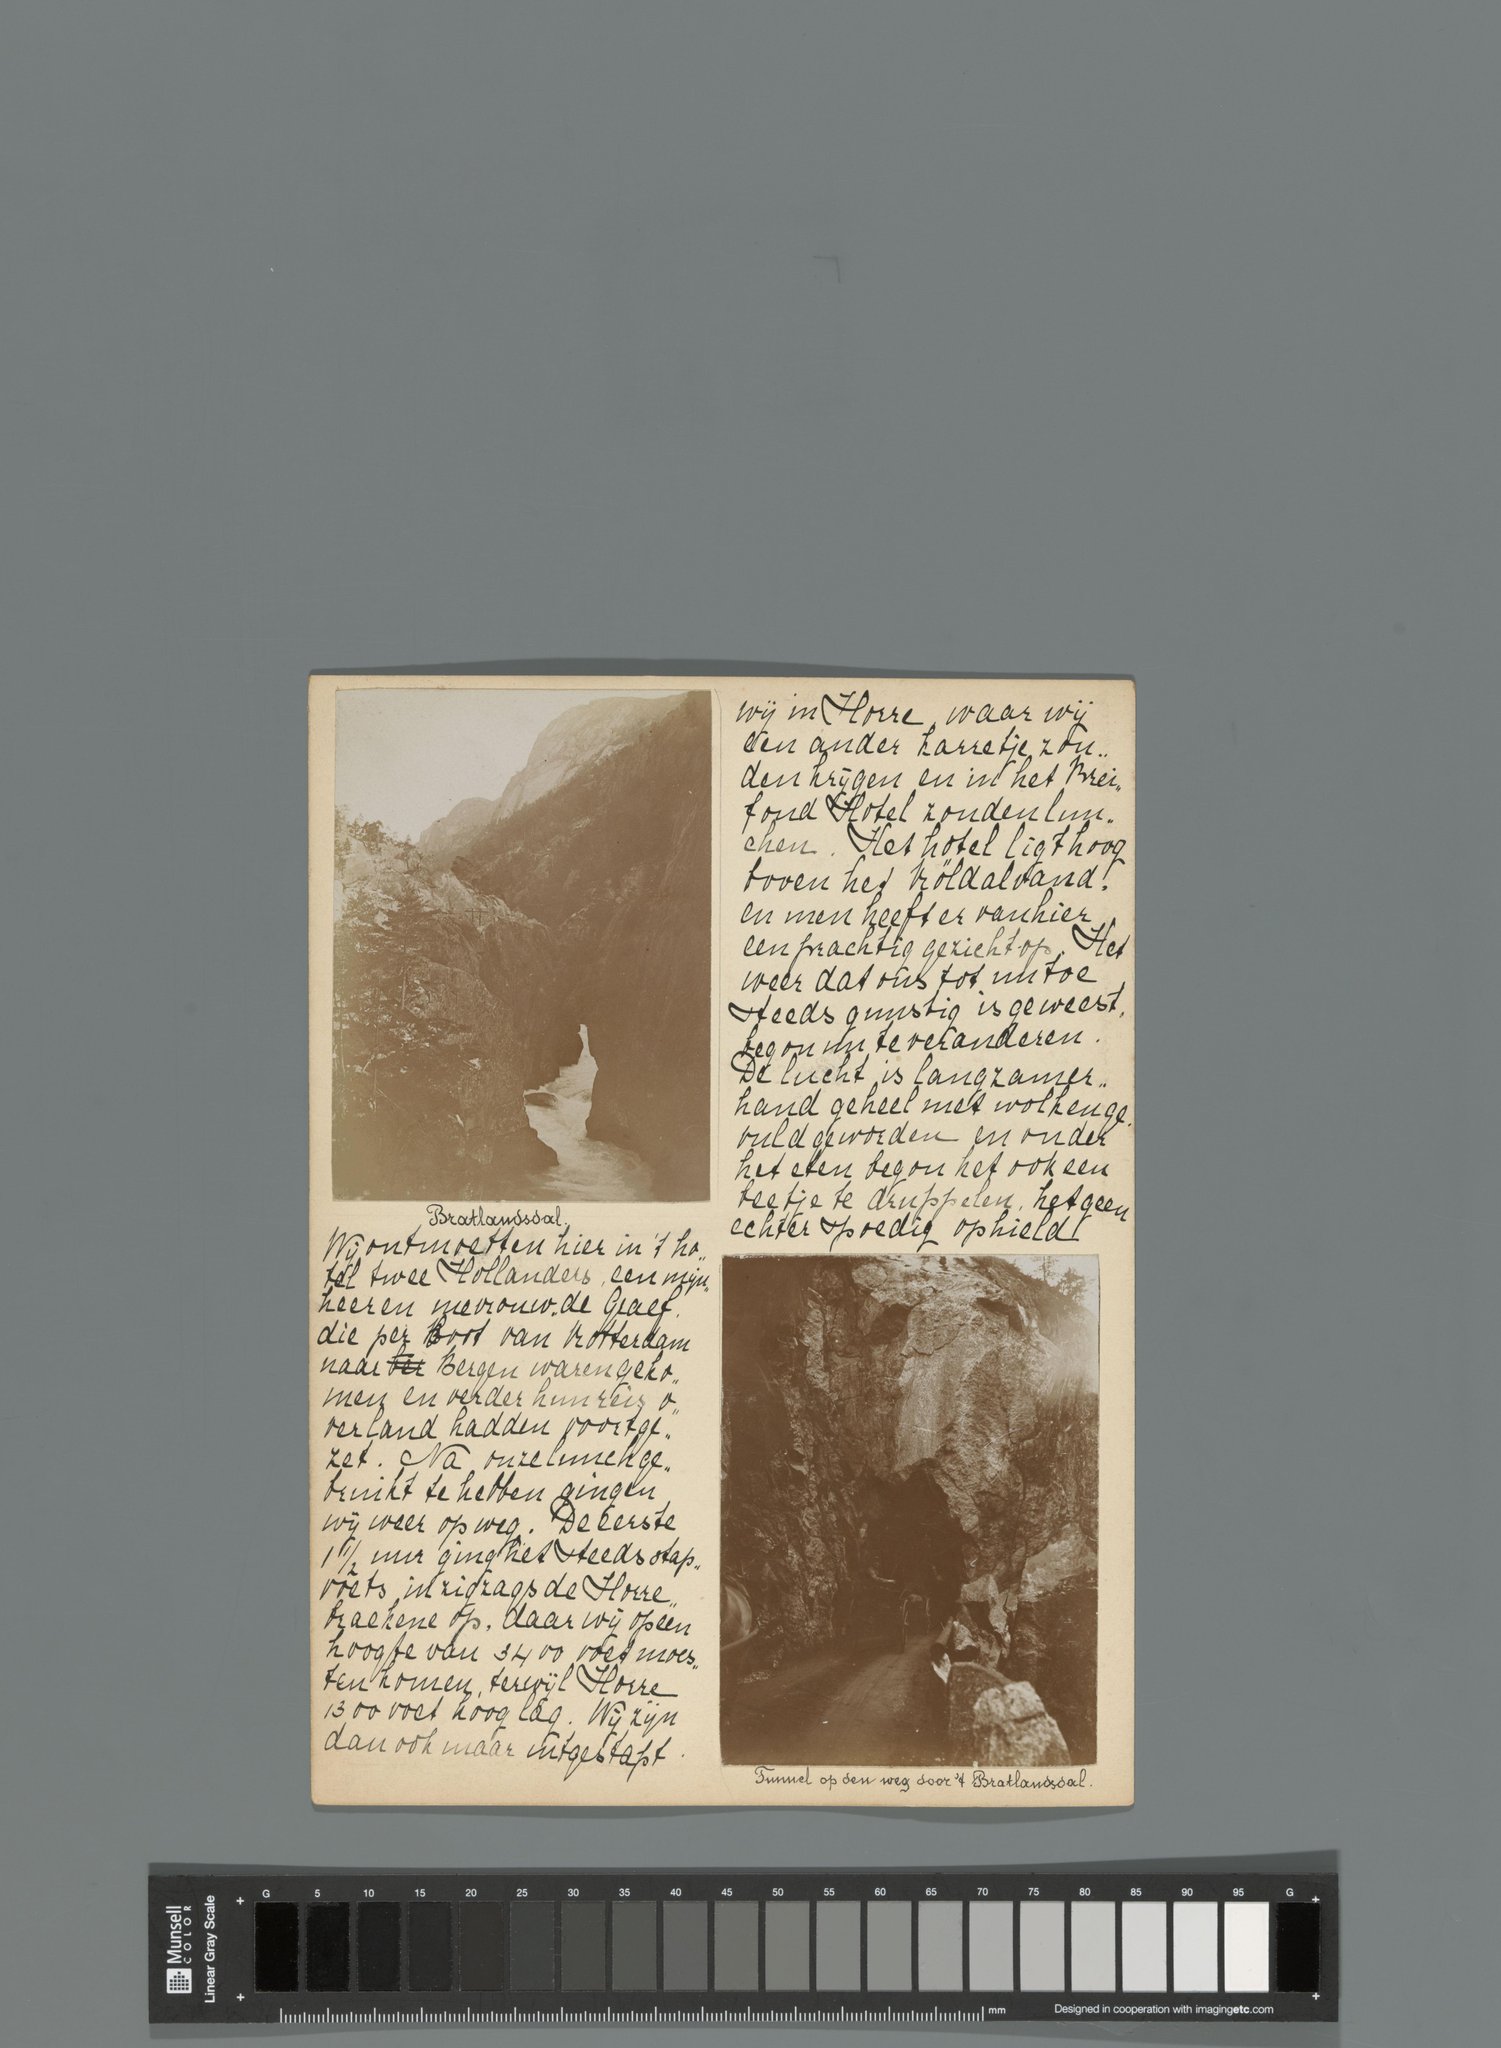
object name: diary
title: Zestiende pagina van een dagboek van een reis door Noorwegen met twee foto's met gezichten op Brattlandsdalen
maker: hendrik herman van den berg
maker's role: amateurfotograaf, jurist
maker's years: 1875-1944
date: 1895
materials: paper, ink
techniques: pen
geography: brattlandsdalen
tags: batavia, amsterdam, hendrik herman van den berg, ravine, chasm, abyss, canyon, handwriting, written text, 'en route', traveller under way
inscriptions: caption: ‘Bratlandsdal./ Tunnel op den weg door 't Bratlandsdal.’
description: Vijftiende pagina van een dagboek met het verslag van een reis door Noorwegen gemaakt door Hendrik Herman van den Berg en zijn neef Guillaume Louis Jacques Holle tussen 5 en 20 juli 1895. Op het dagboekblad zijn twee foto's geplakt met gezichten op Brattlandsdalen.